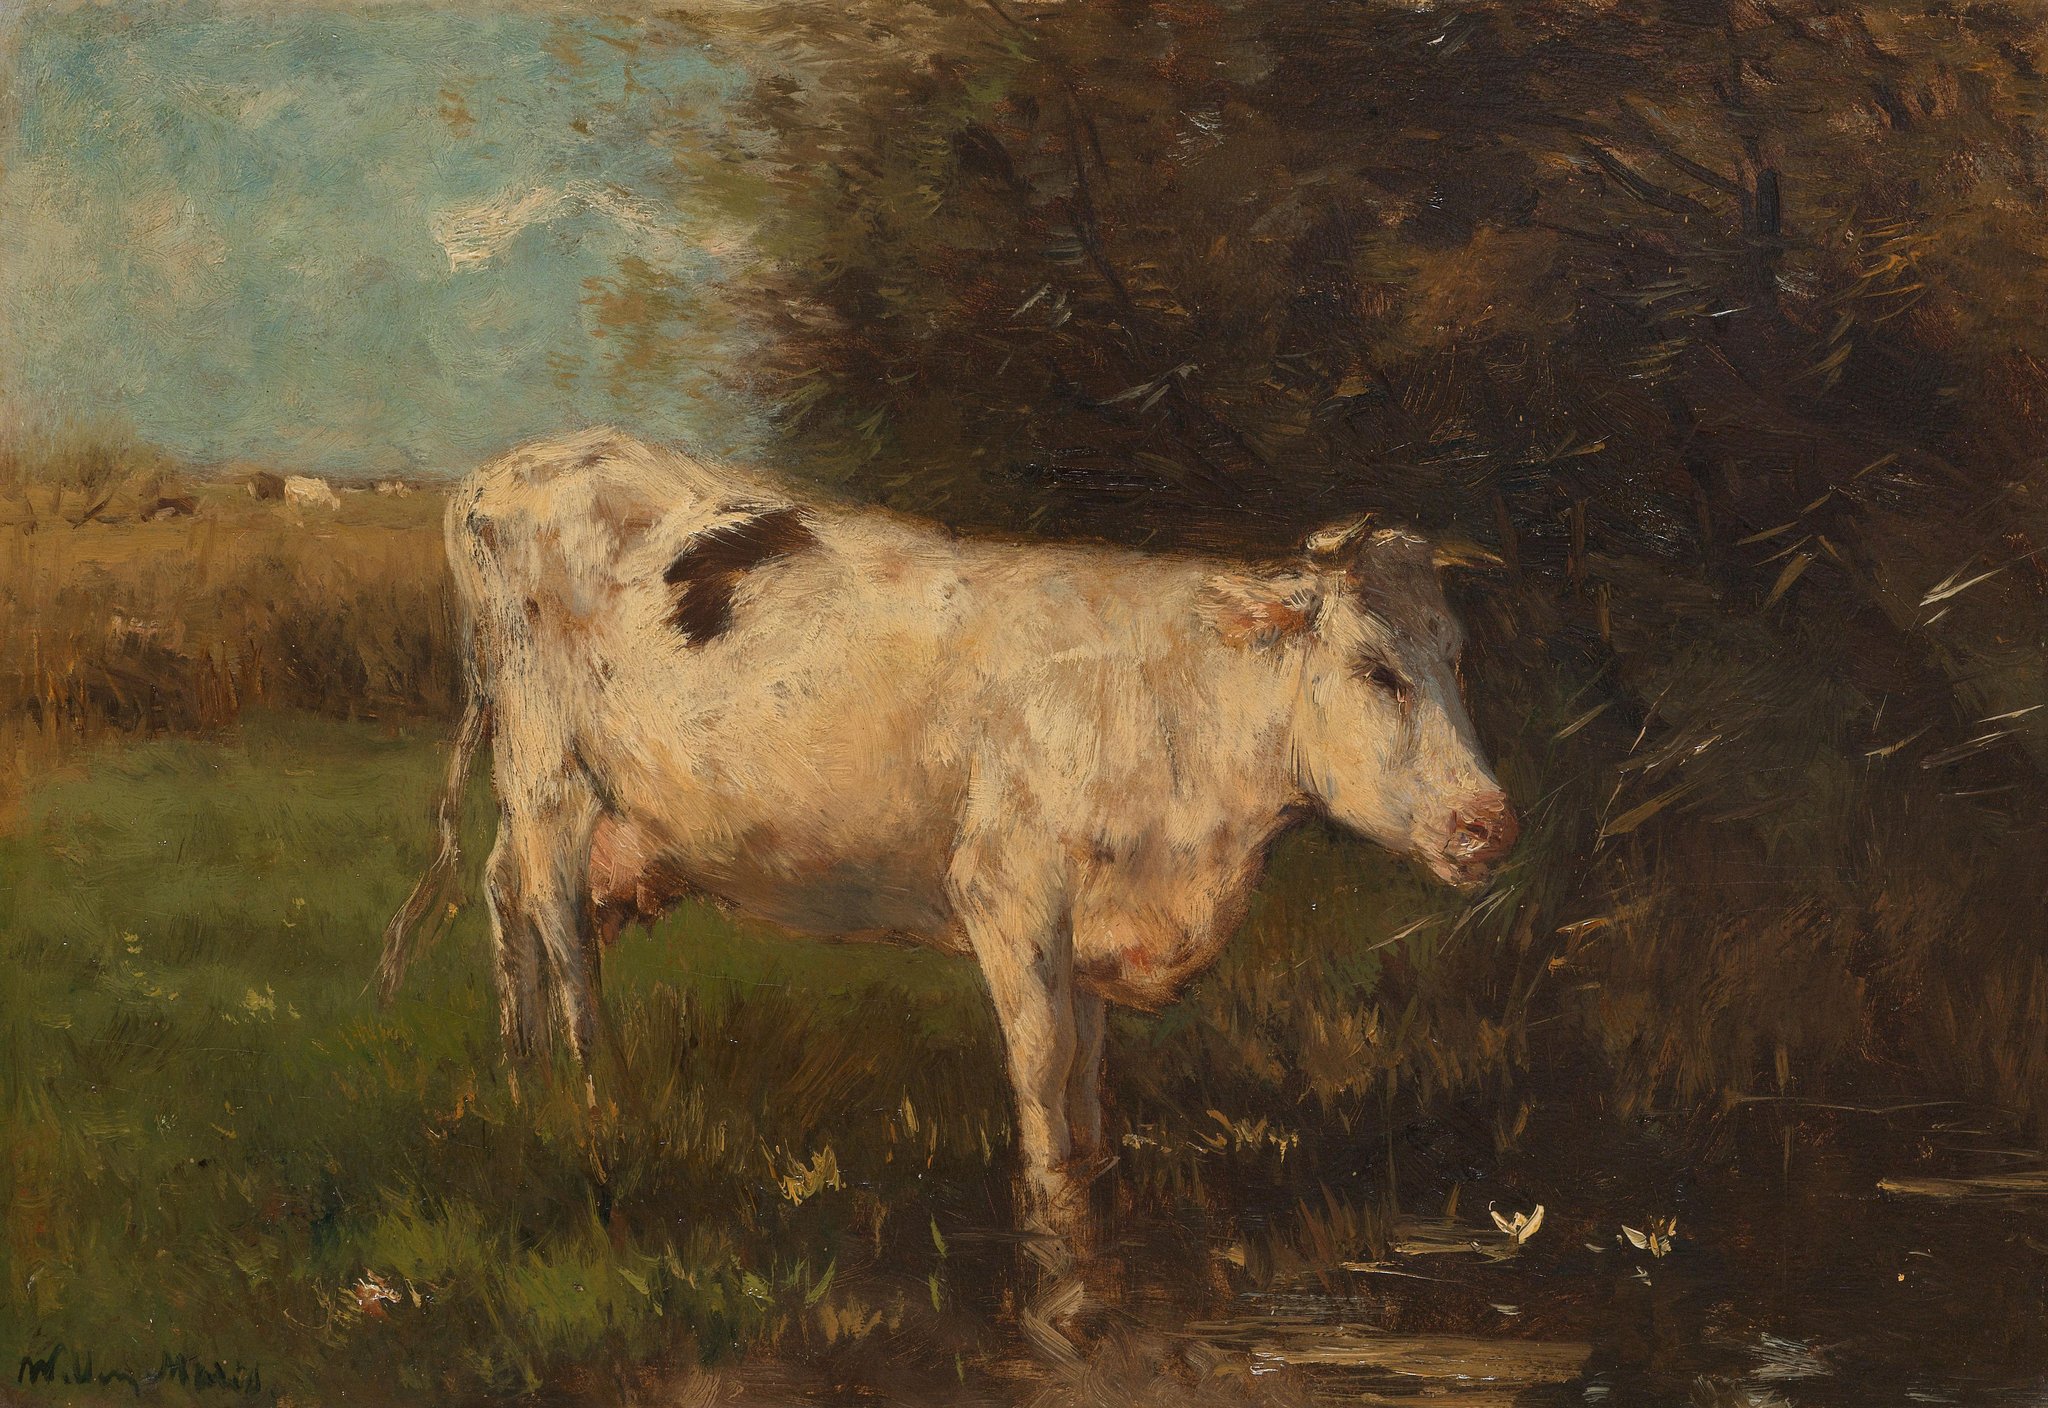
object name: painting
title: White Cow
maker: willem maris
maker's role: draughtsman, painter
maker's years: 1844-1910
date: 1880-1910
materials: oil, panel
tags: cow, meadow, pasture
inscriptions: signature: ‘Willem Maris’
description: Willem Maris may have used this small painting as a preparatory study for several of his large compositions with a cow. From the cow’s contours, it is clear that it was painted in light colours over a dark brown ground. Willem Maris was the only artist in his group who consistently worked in this way. Most Hague School painters used a light ground.